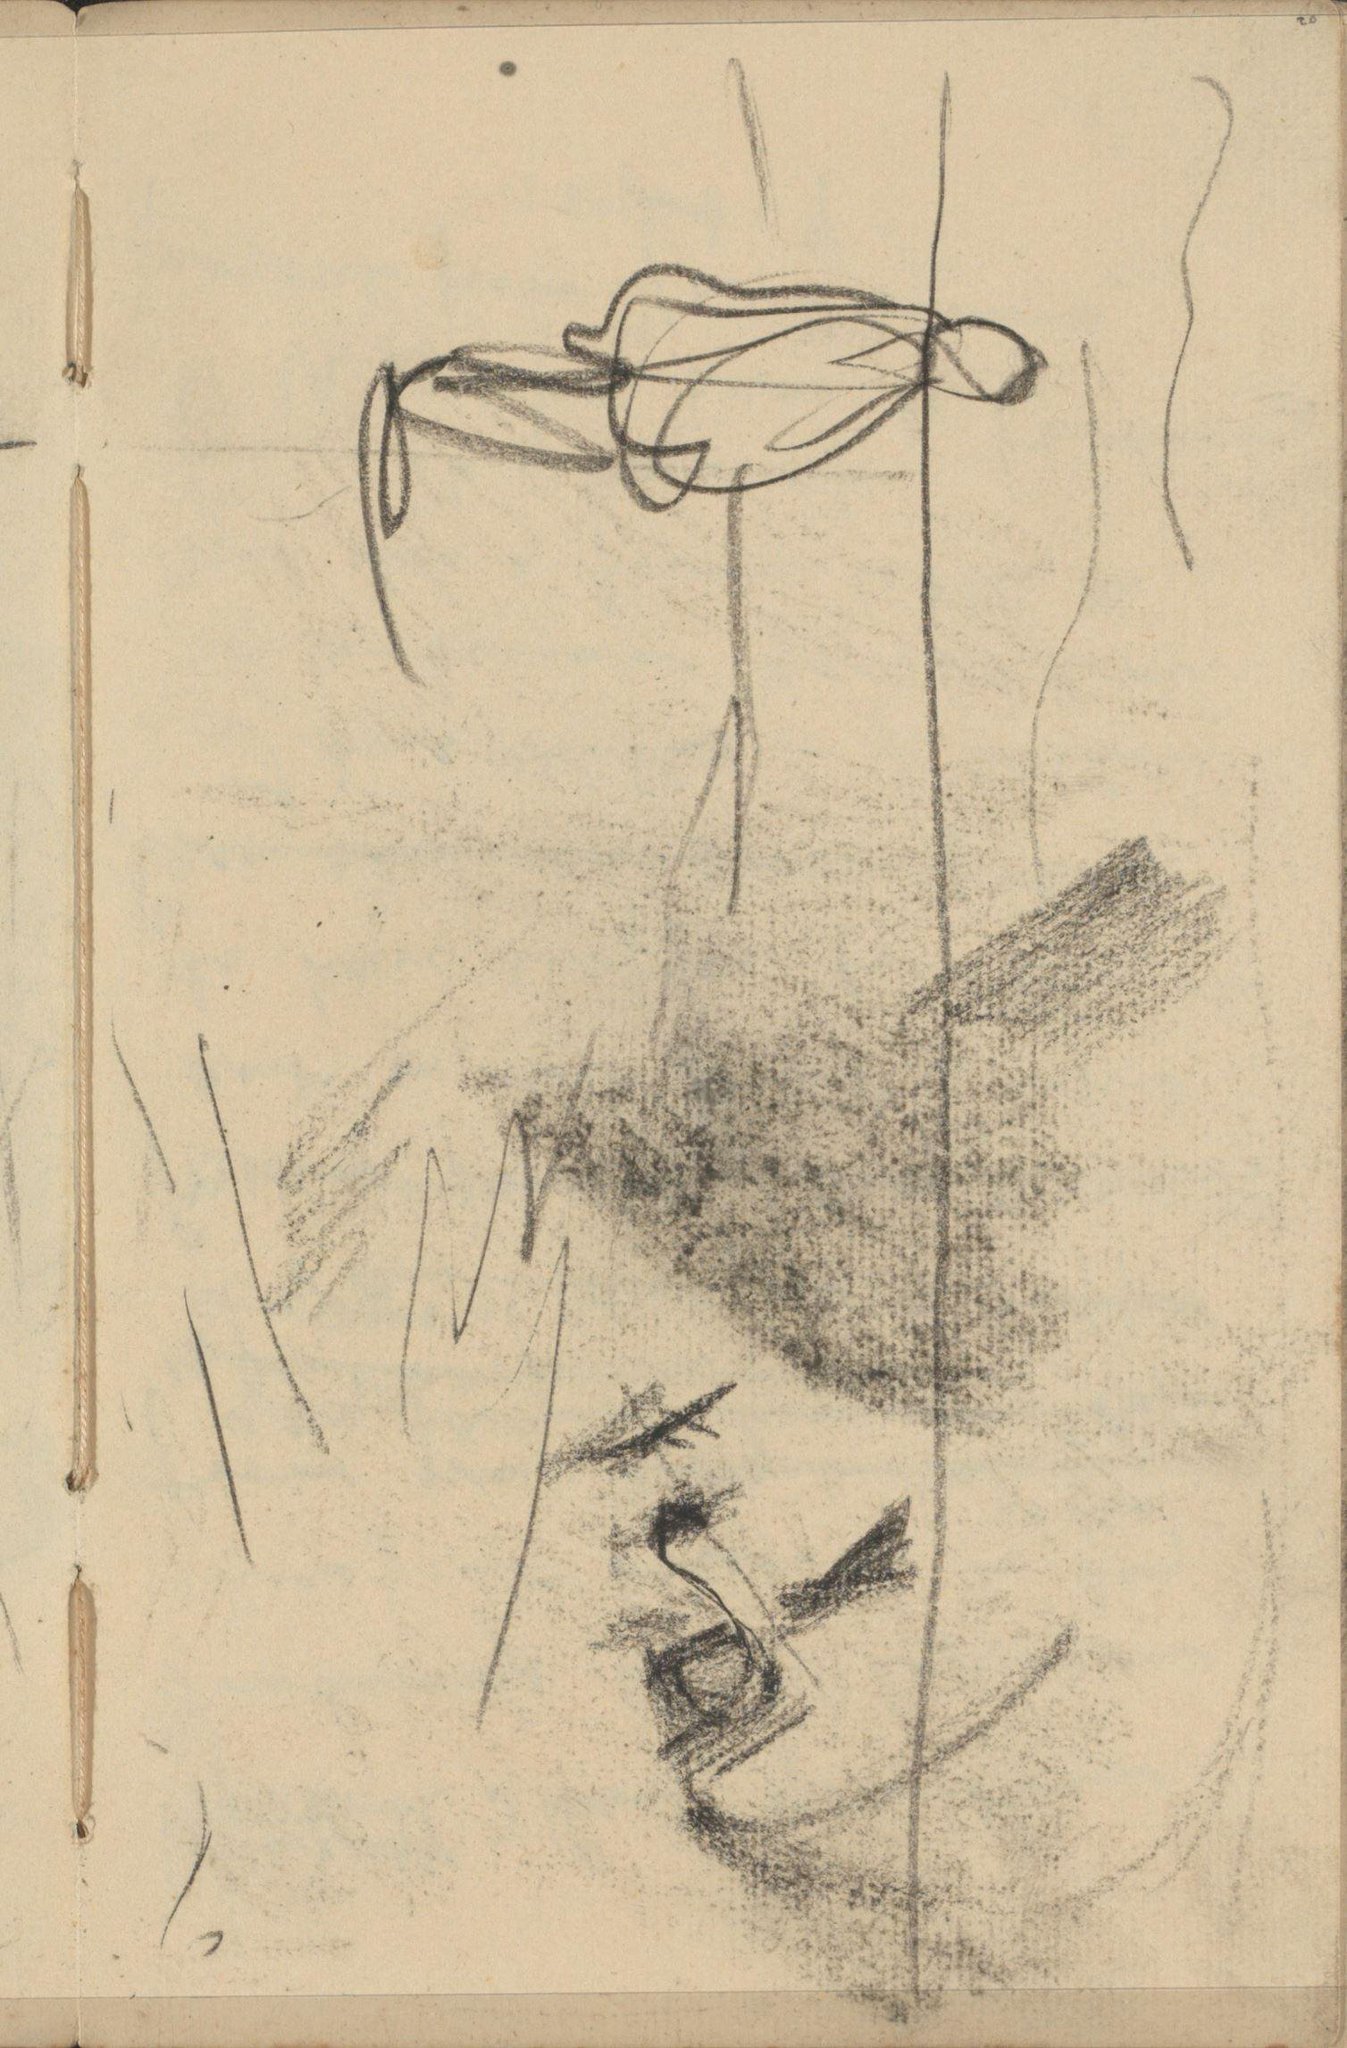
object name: sketchbook leaf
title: Figuur in een landschap en een gezicht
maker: george hendrik breitner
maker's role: draughtsman, painter, print maker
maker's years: 1857-1923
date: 1882-1884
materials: chalk, paper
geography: the hague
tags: face, landscapes (+ landscape with figures, staffage)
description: Pagina 20 uit een schetsboek met 24 bladen.